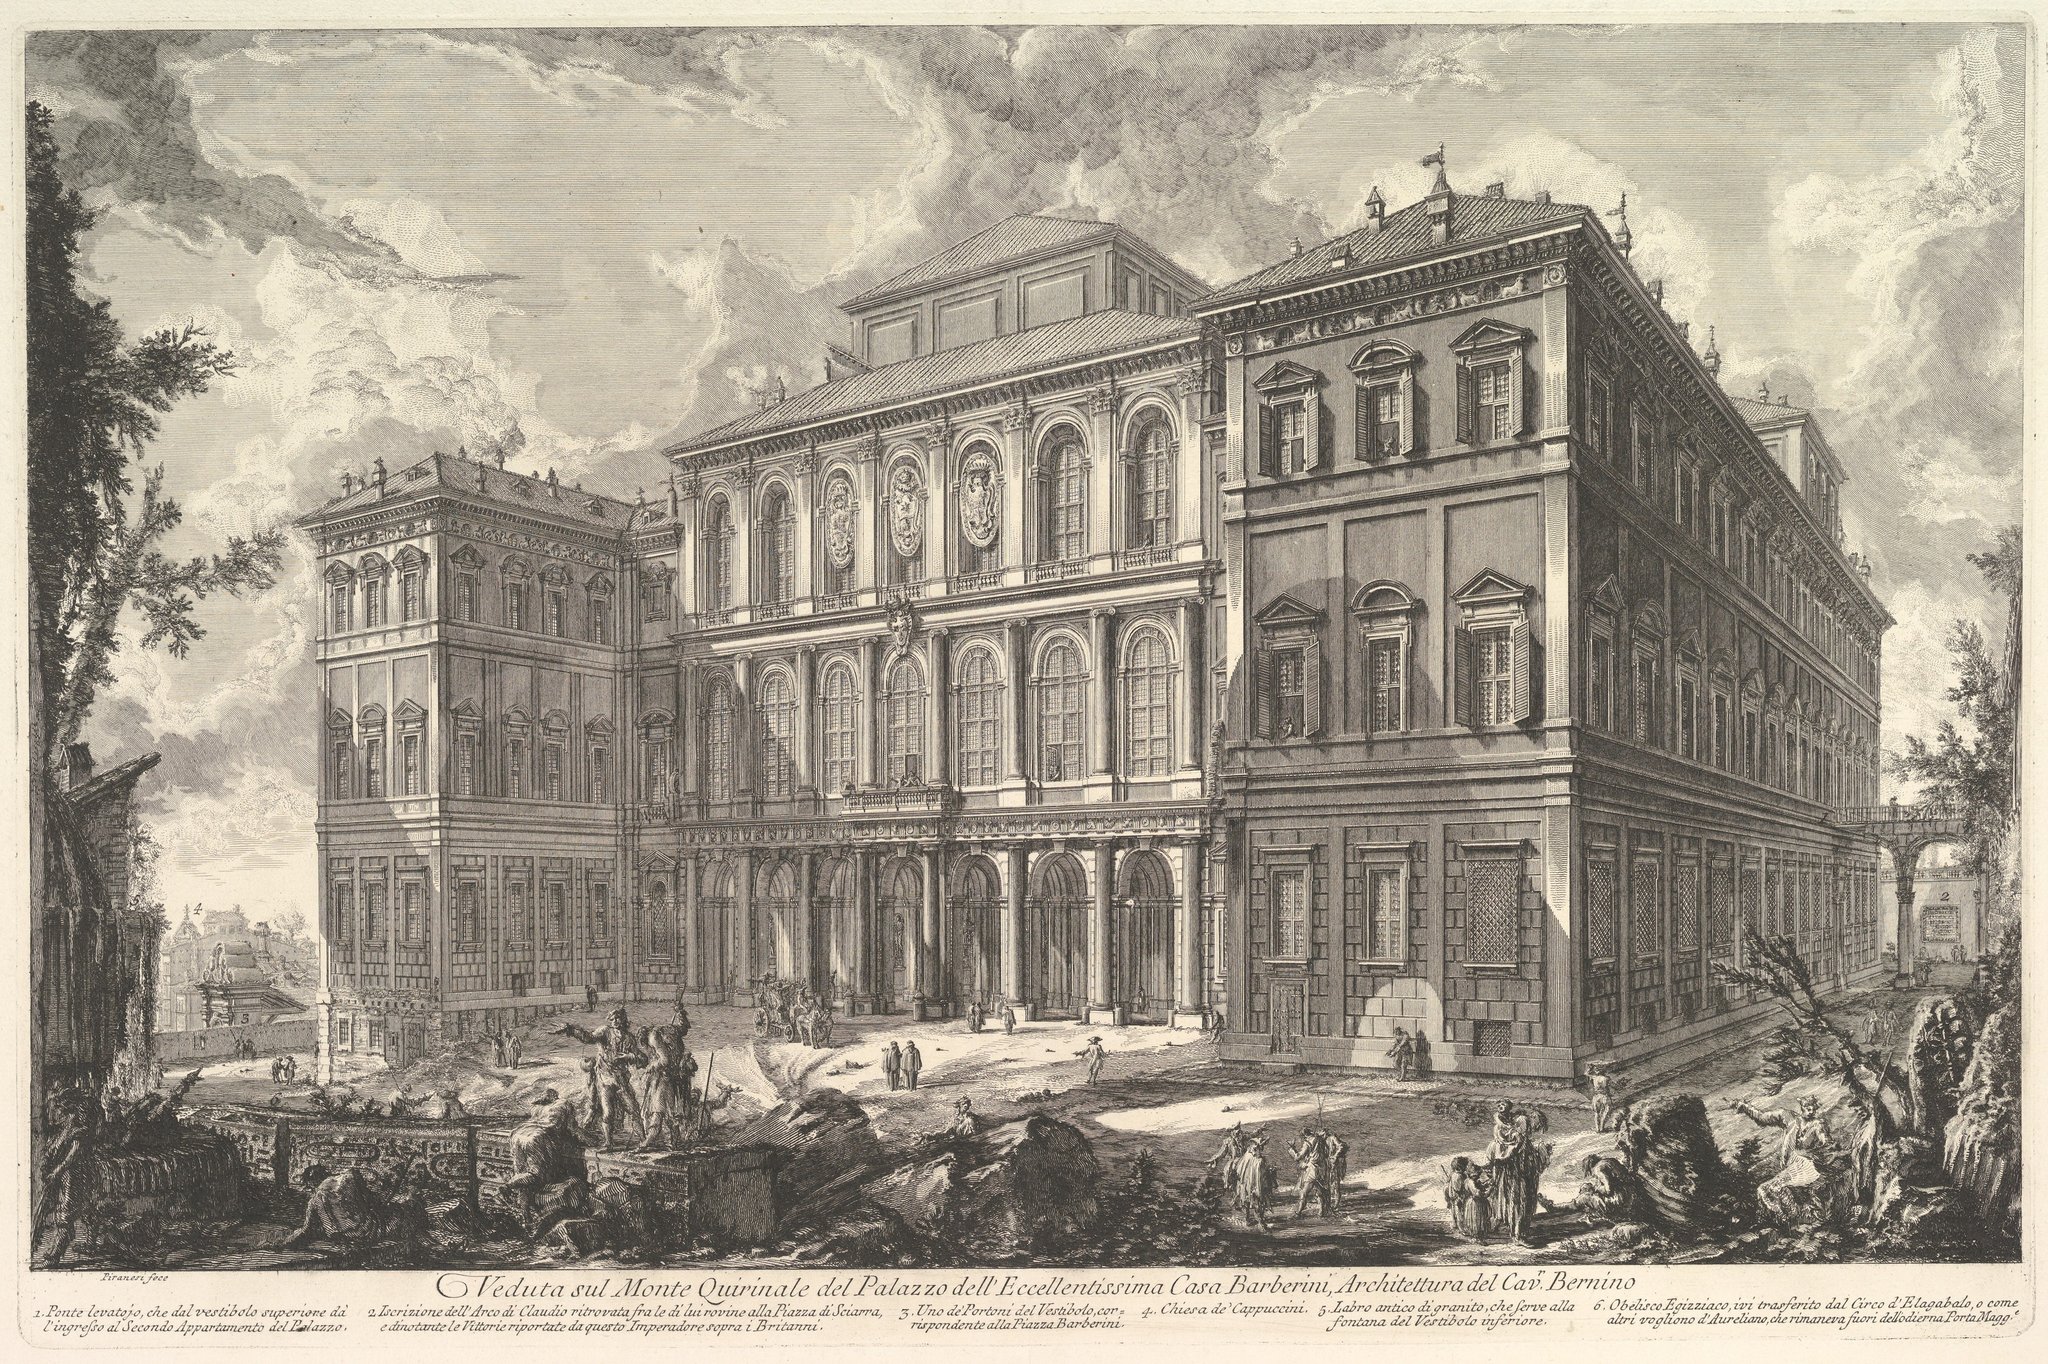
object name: print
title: View of the palace of the illustrious Barberini family on the Quirinal Hill, designed by Cavaliere Bernini, from Vedute di Roma (Roman Views)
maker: giovanni battista piranesi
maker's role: artist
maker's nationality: italian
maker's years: 1720-1778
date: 1750-1759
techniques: etching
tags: palaces,rome